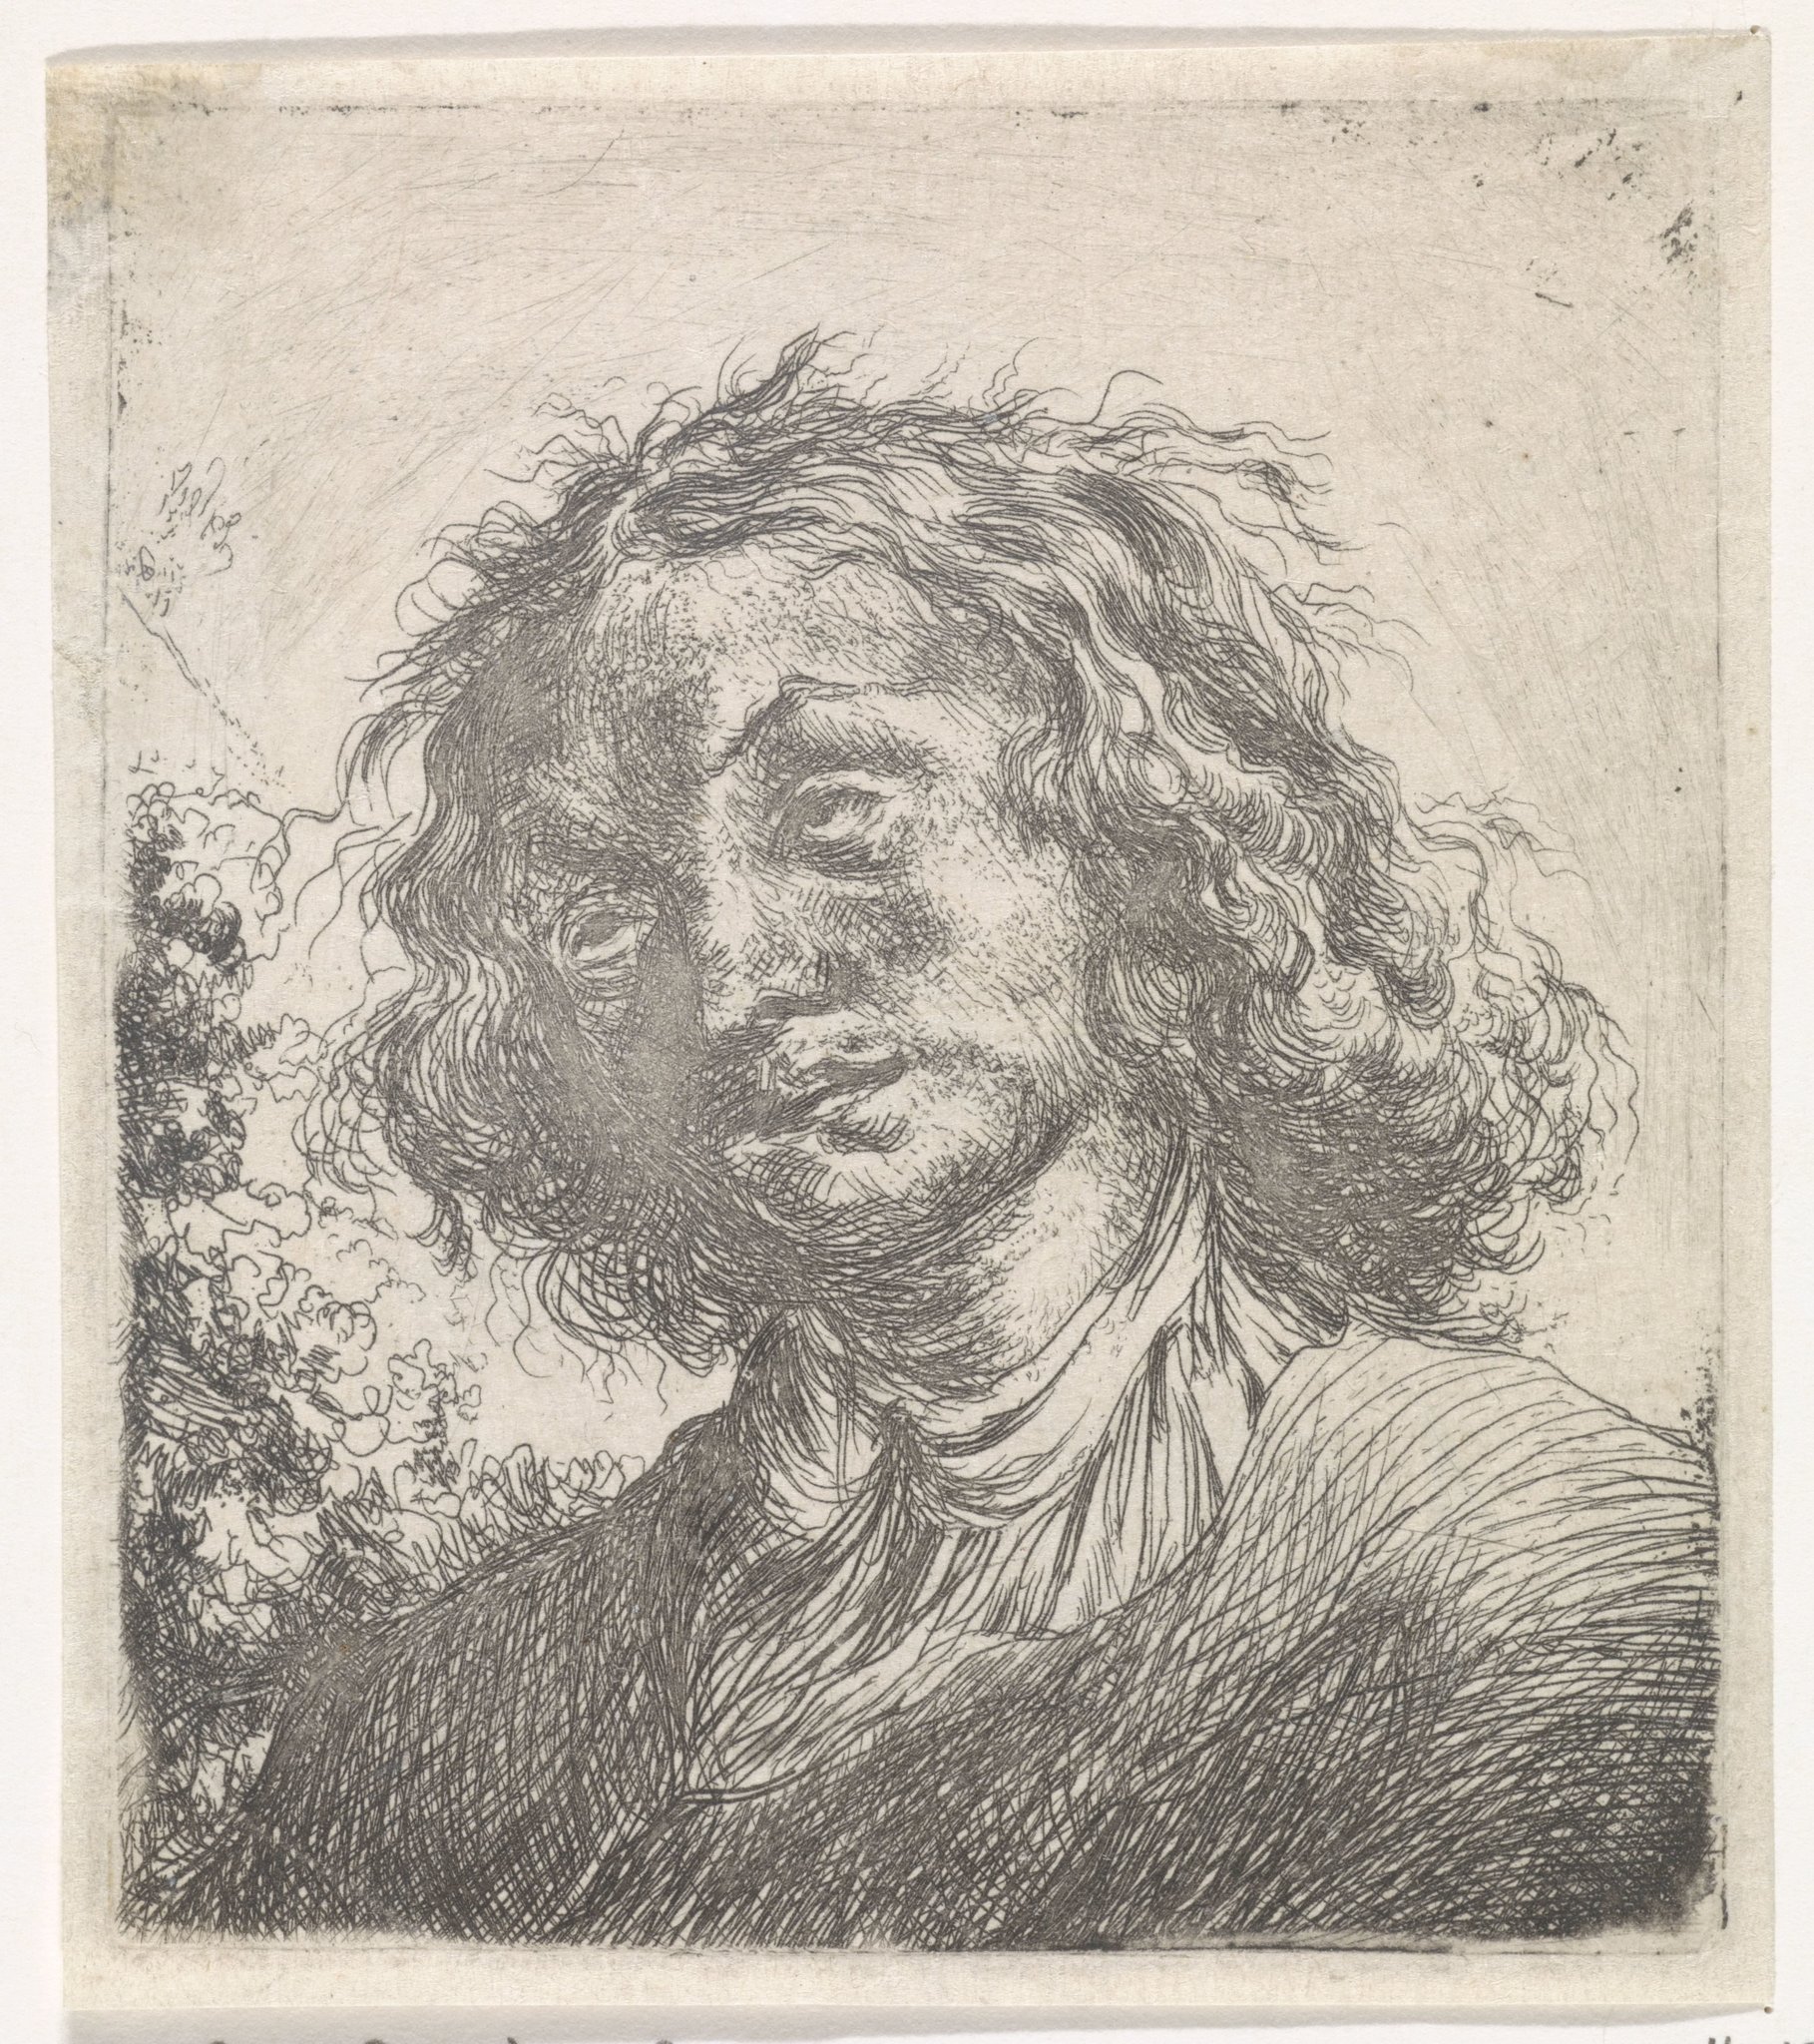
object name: print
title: Portret van een man met lange haren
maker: carel de moor (ii)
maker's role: draughtsman, painter, print maker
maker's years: 1655-1738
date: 1665-1738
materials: paper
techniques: etching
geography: netherlands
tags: adult man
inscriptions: collector's mark: Lugt 2228